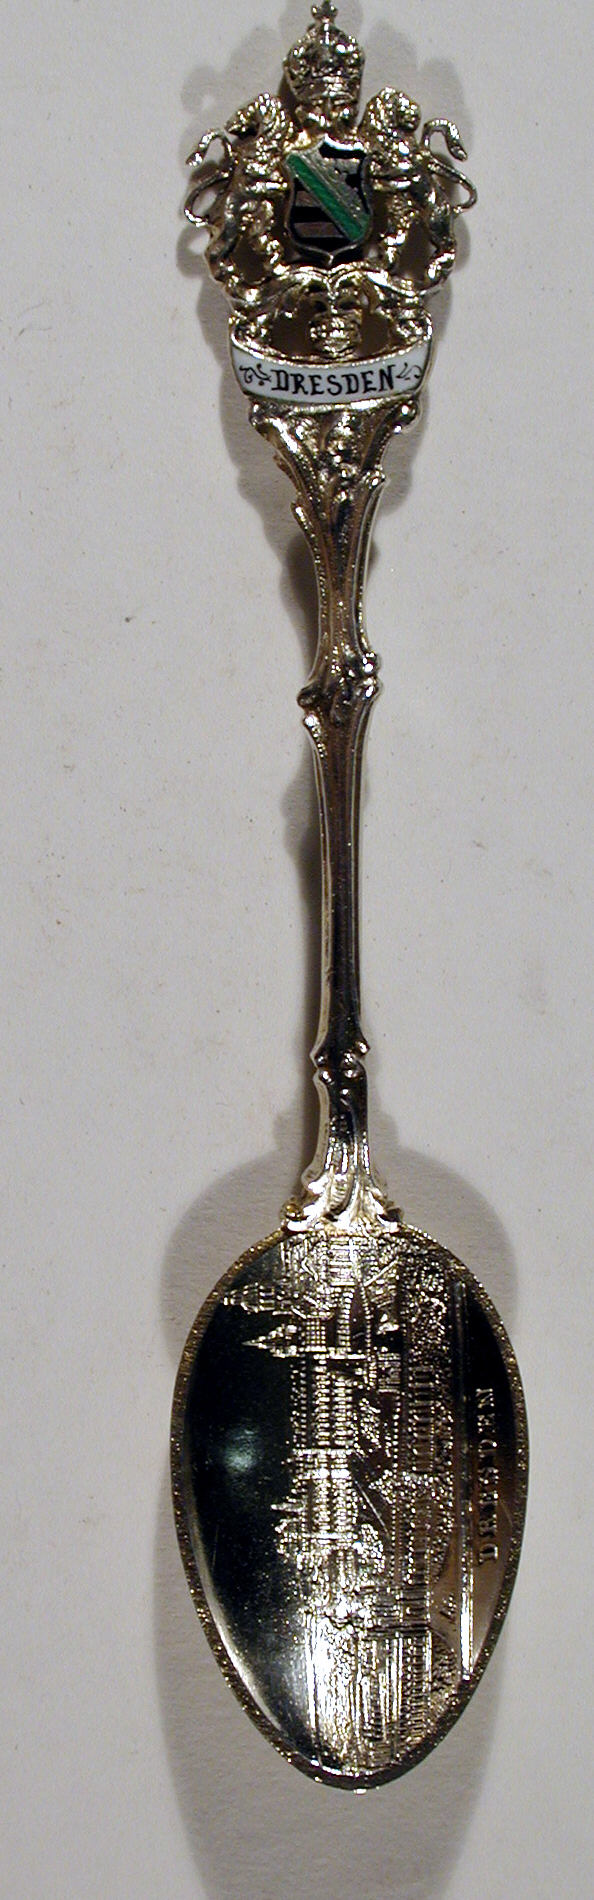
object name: souvenir spoon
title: Souvenir spoon with view of the Zwinger in Dresden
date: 1867-1900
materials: enamel, silver gilt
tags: palaces,lions,coat of arms